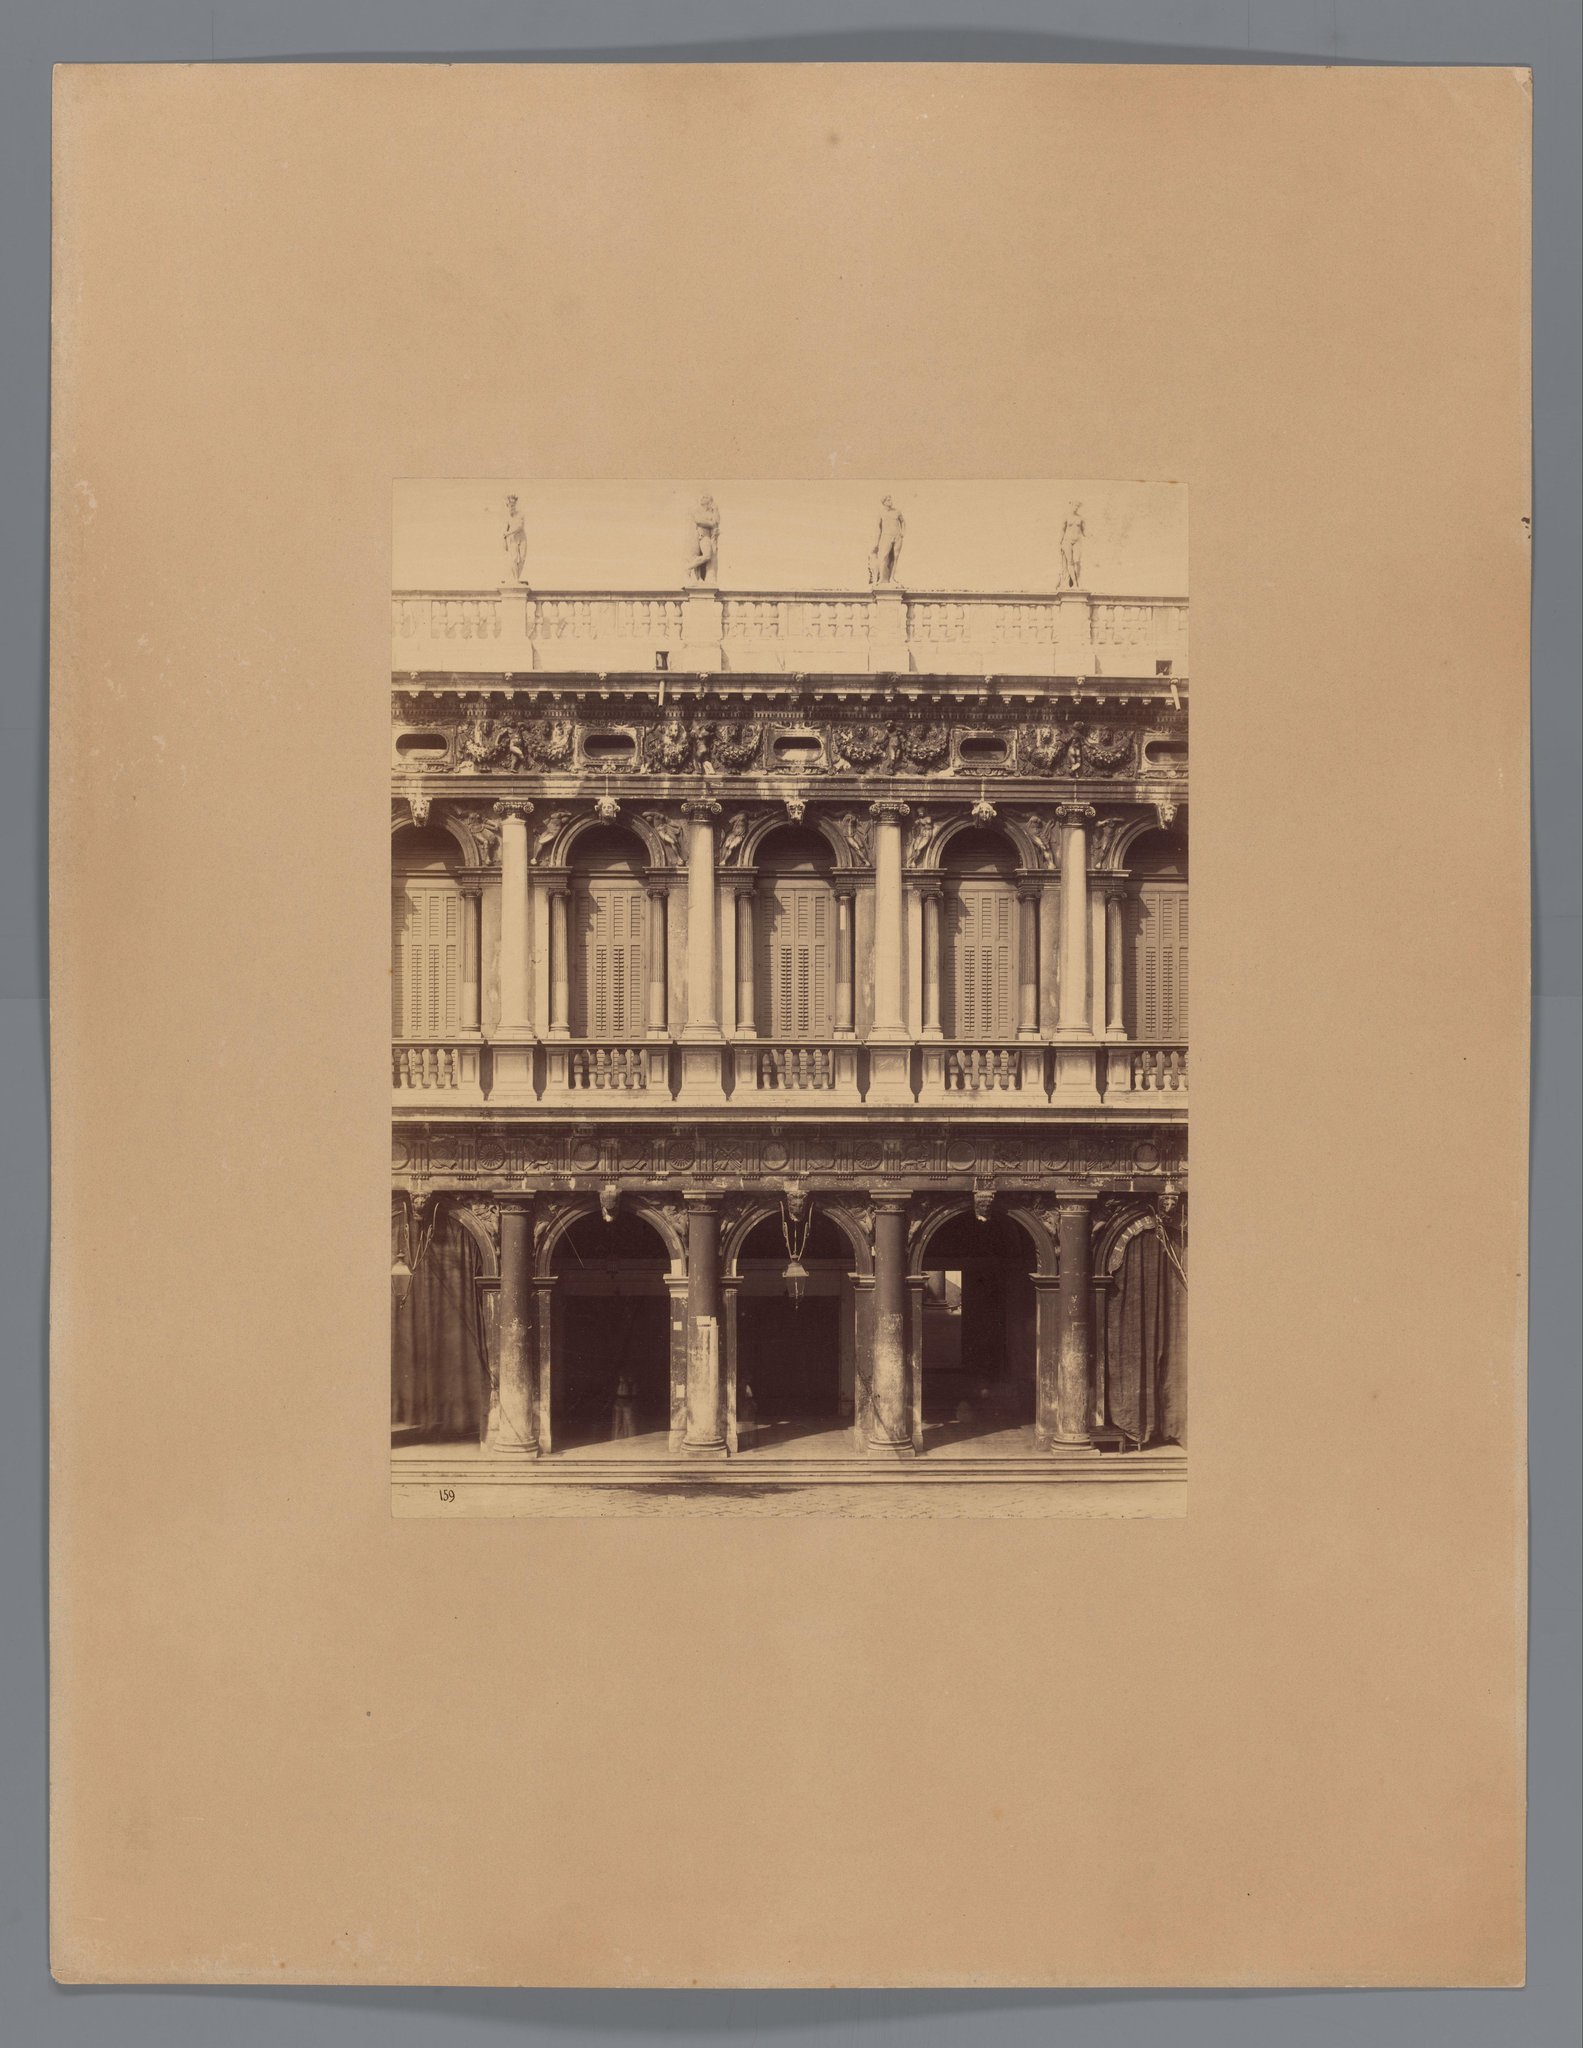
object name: photograph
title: Paleis tegenover het Dogenpaleis te Venetië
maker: carlo naya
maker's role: fotograaf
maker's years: 1816-1882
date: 1850-1900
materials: cardboard, photographic support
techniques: albumen print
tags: venice